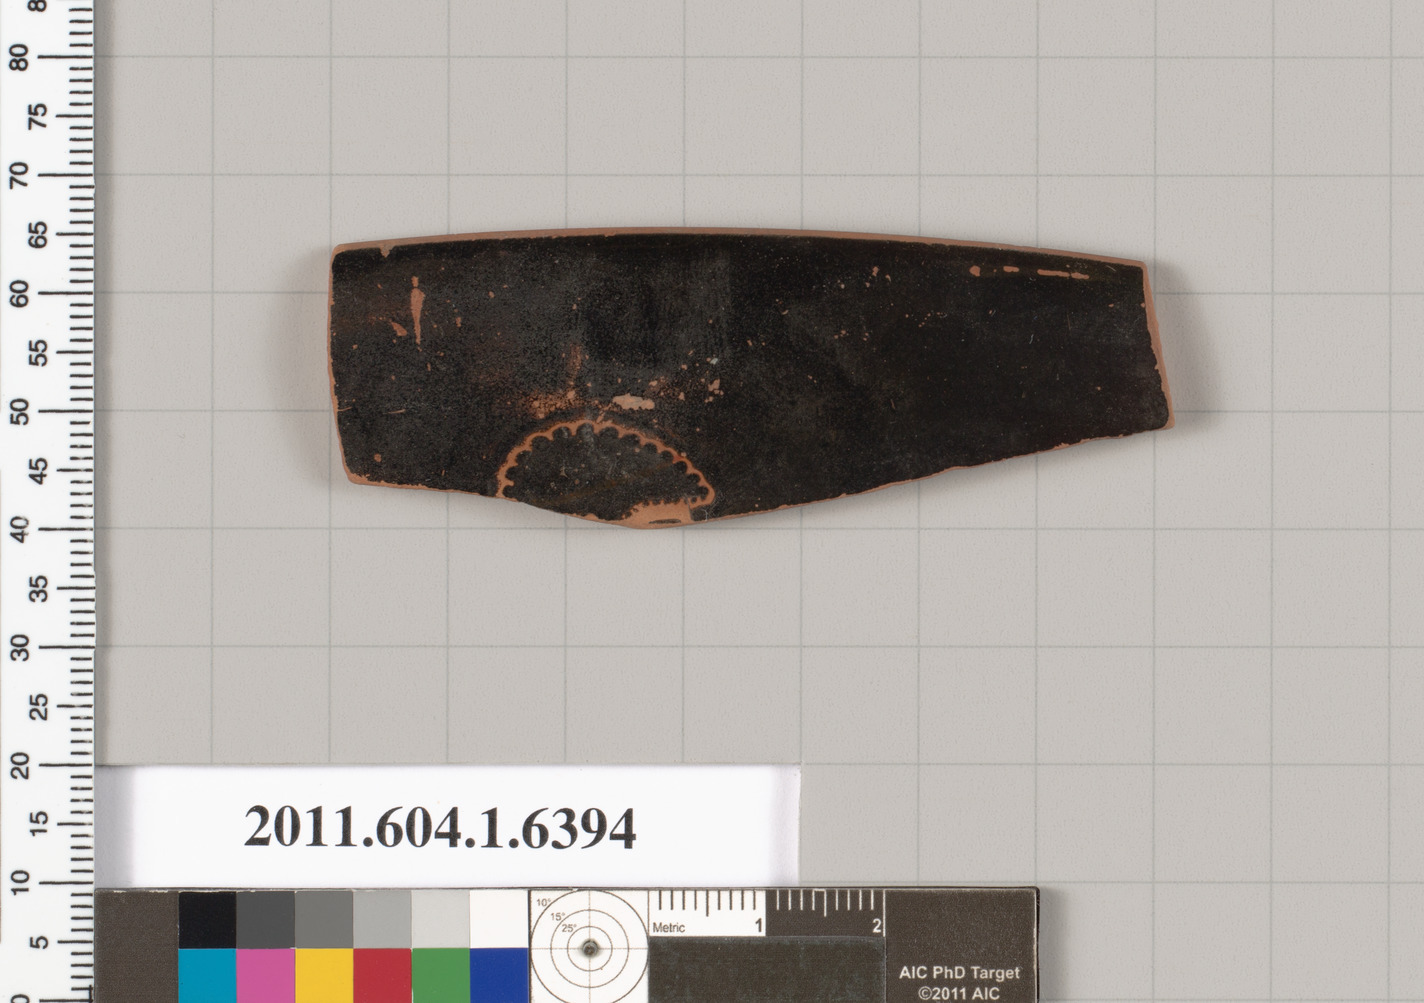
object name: kylix fragment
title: Terracotta rim fragment of a kylix (drinking cup)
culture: greek, attic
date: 490-480 BCE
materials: terracotta